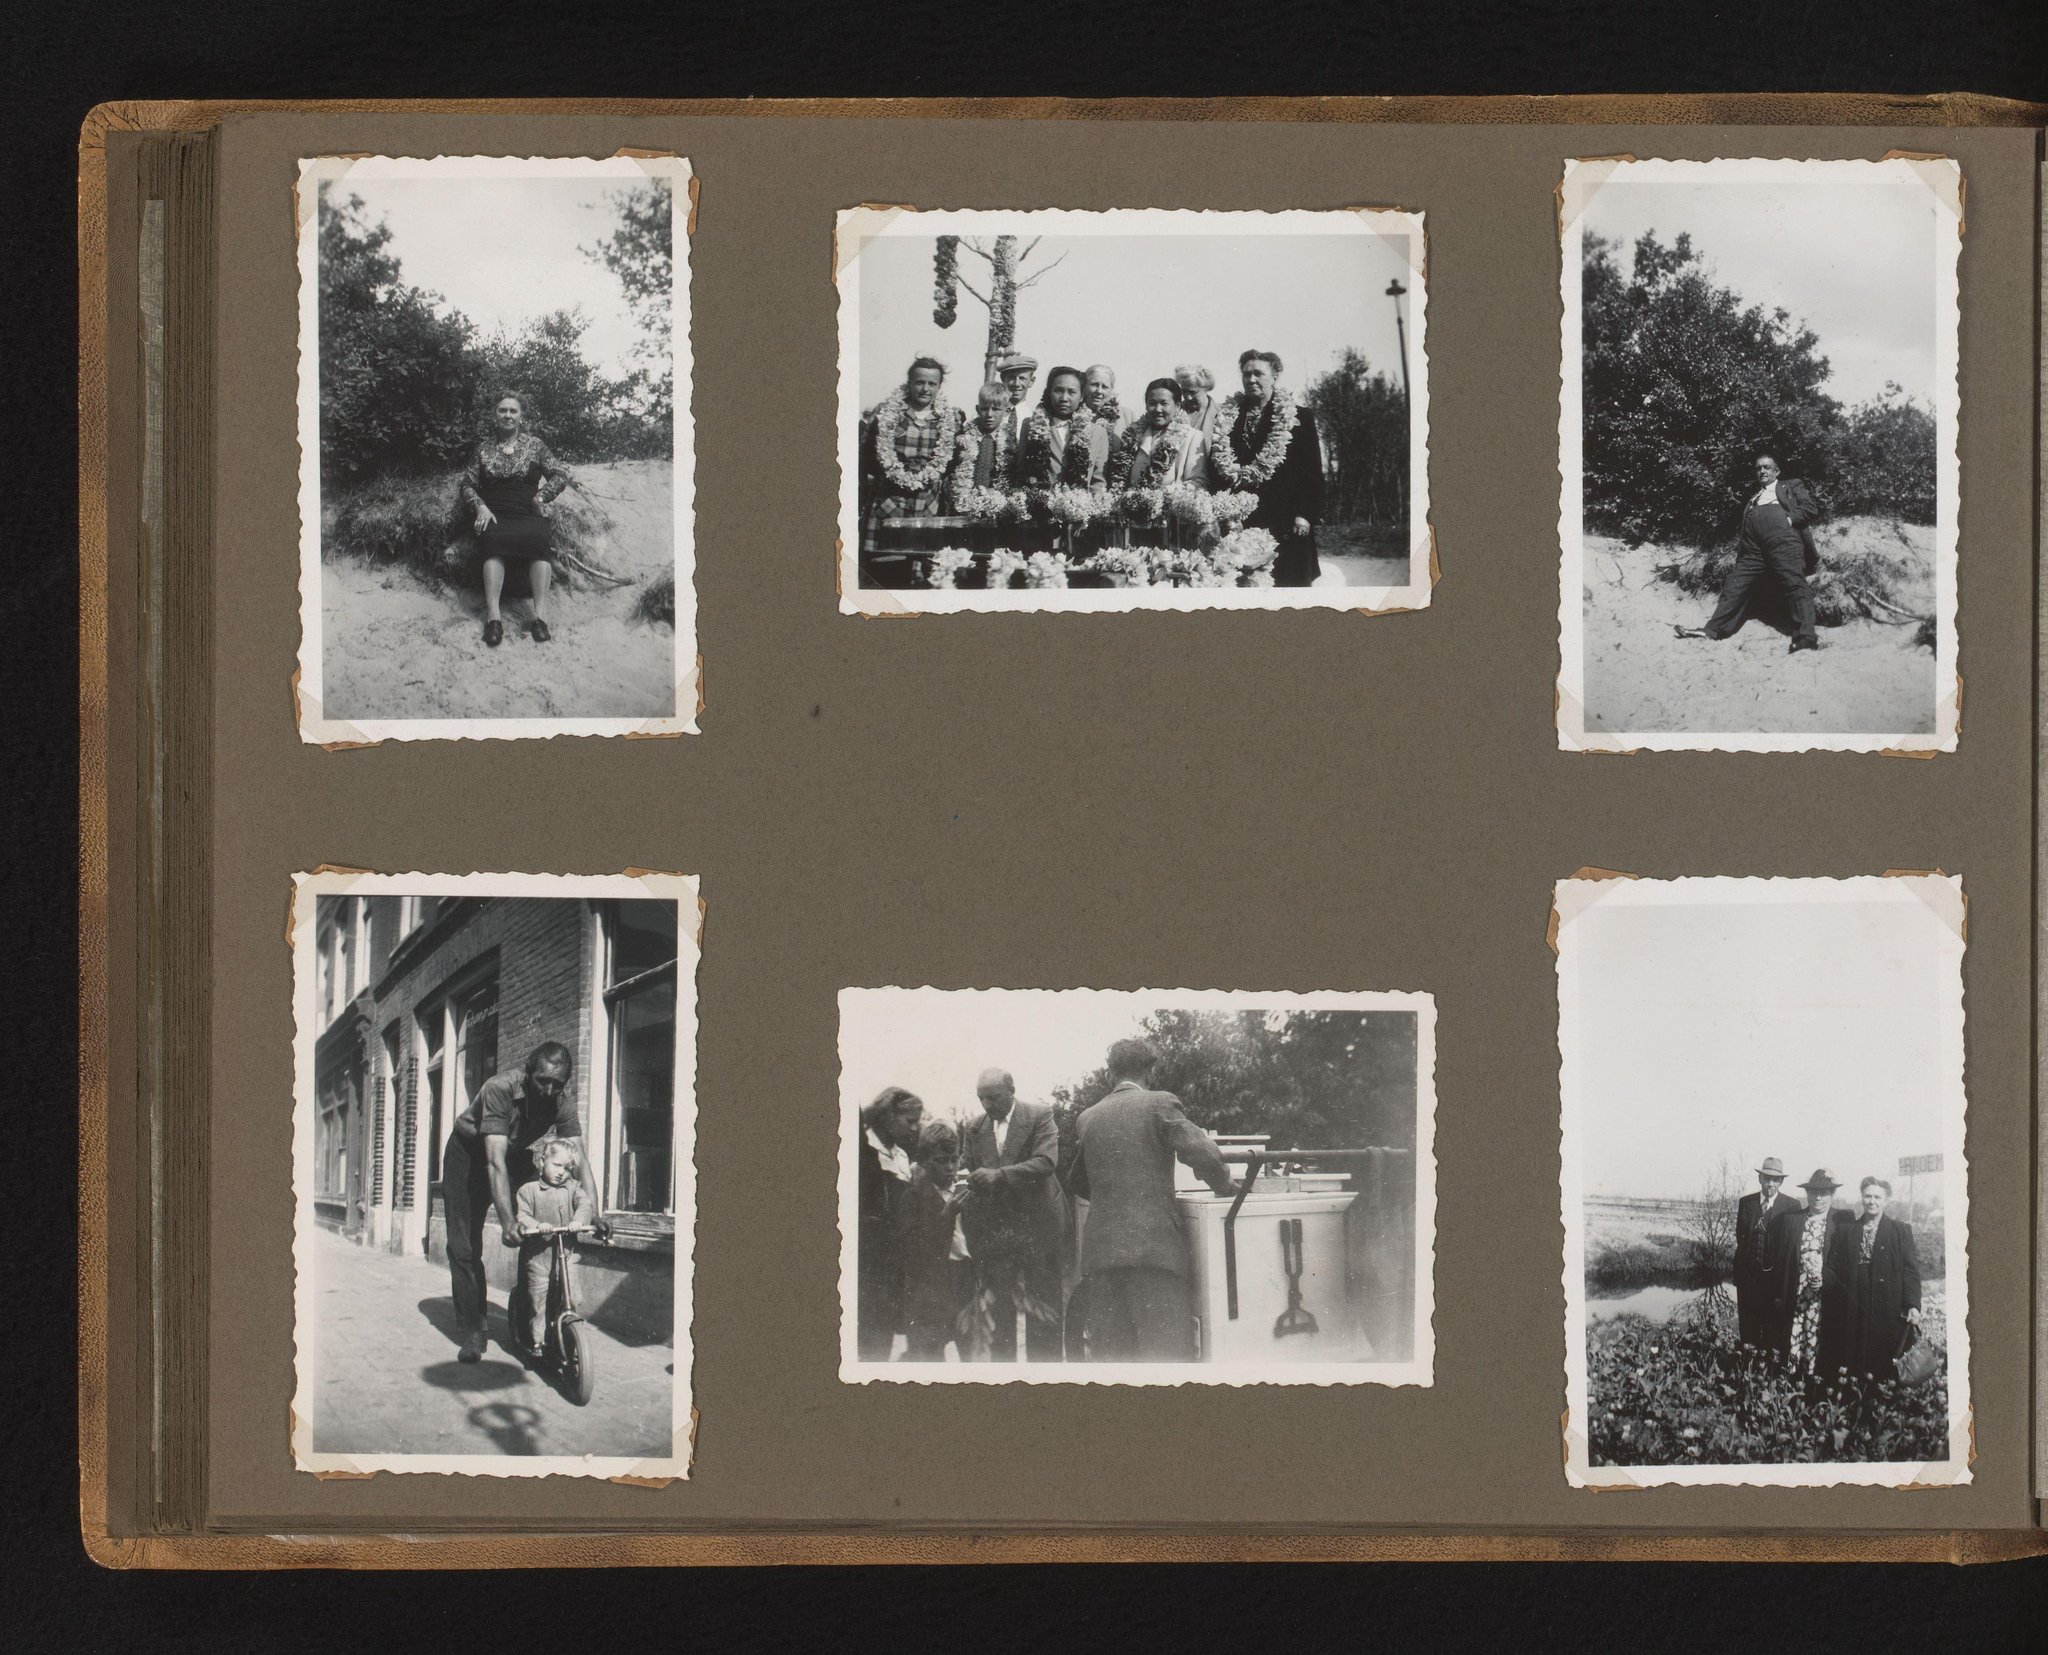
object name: photograph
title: Diverse afbeeldingen waaronder een groepsportret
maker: Anonymous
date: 1900-1950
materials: photographic support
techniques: gelatin silver print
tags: flowers, adult woman, adult man, child, historical persons, anonymous historical persons portrayed in a group, in a group-portrait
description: Portret van een man, portret van een vrouw, een vader met een kind op de step, een ijscoman en twee vrouwen met een man in een veld met bloemen. Deze pagina maakt deel uit van een album.